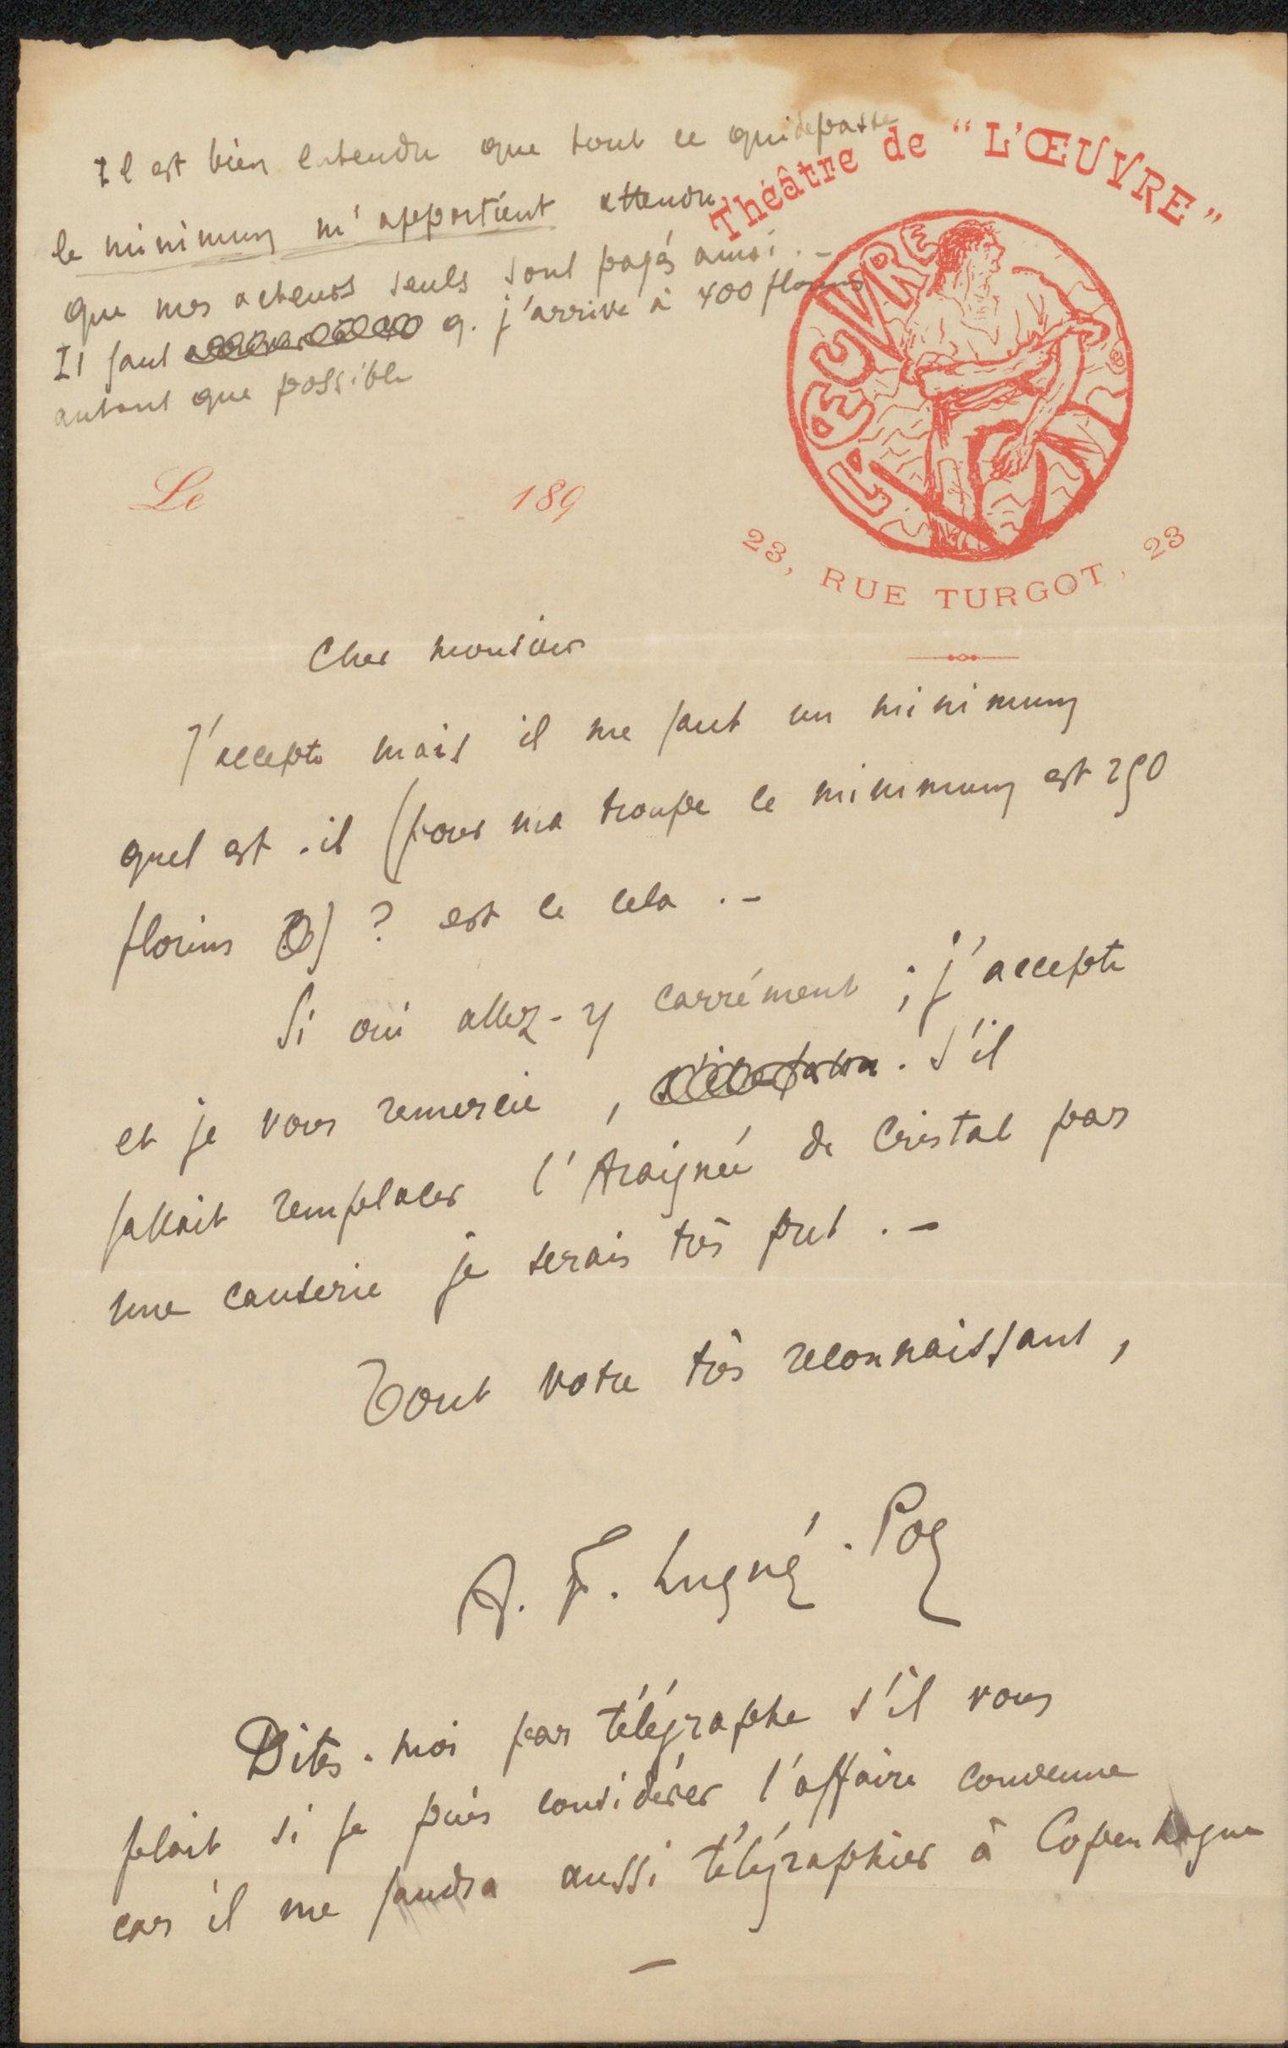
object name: letter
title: Brief aan Philip Zilcken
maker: lugné-poe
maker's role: acteur, theaterdirecteur, theatervormgever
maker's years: 1869-1940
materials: ink, paper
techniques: pen, printing, writing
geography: paris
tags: the hague, draughtsman, philip zilcken, money, copenhagen (city)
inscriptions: watermark, collector's mark: ‘RPK’